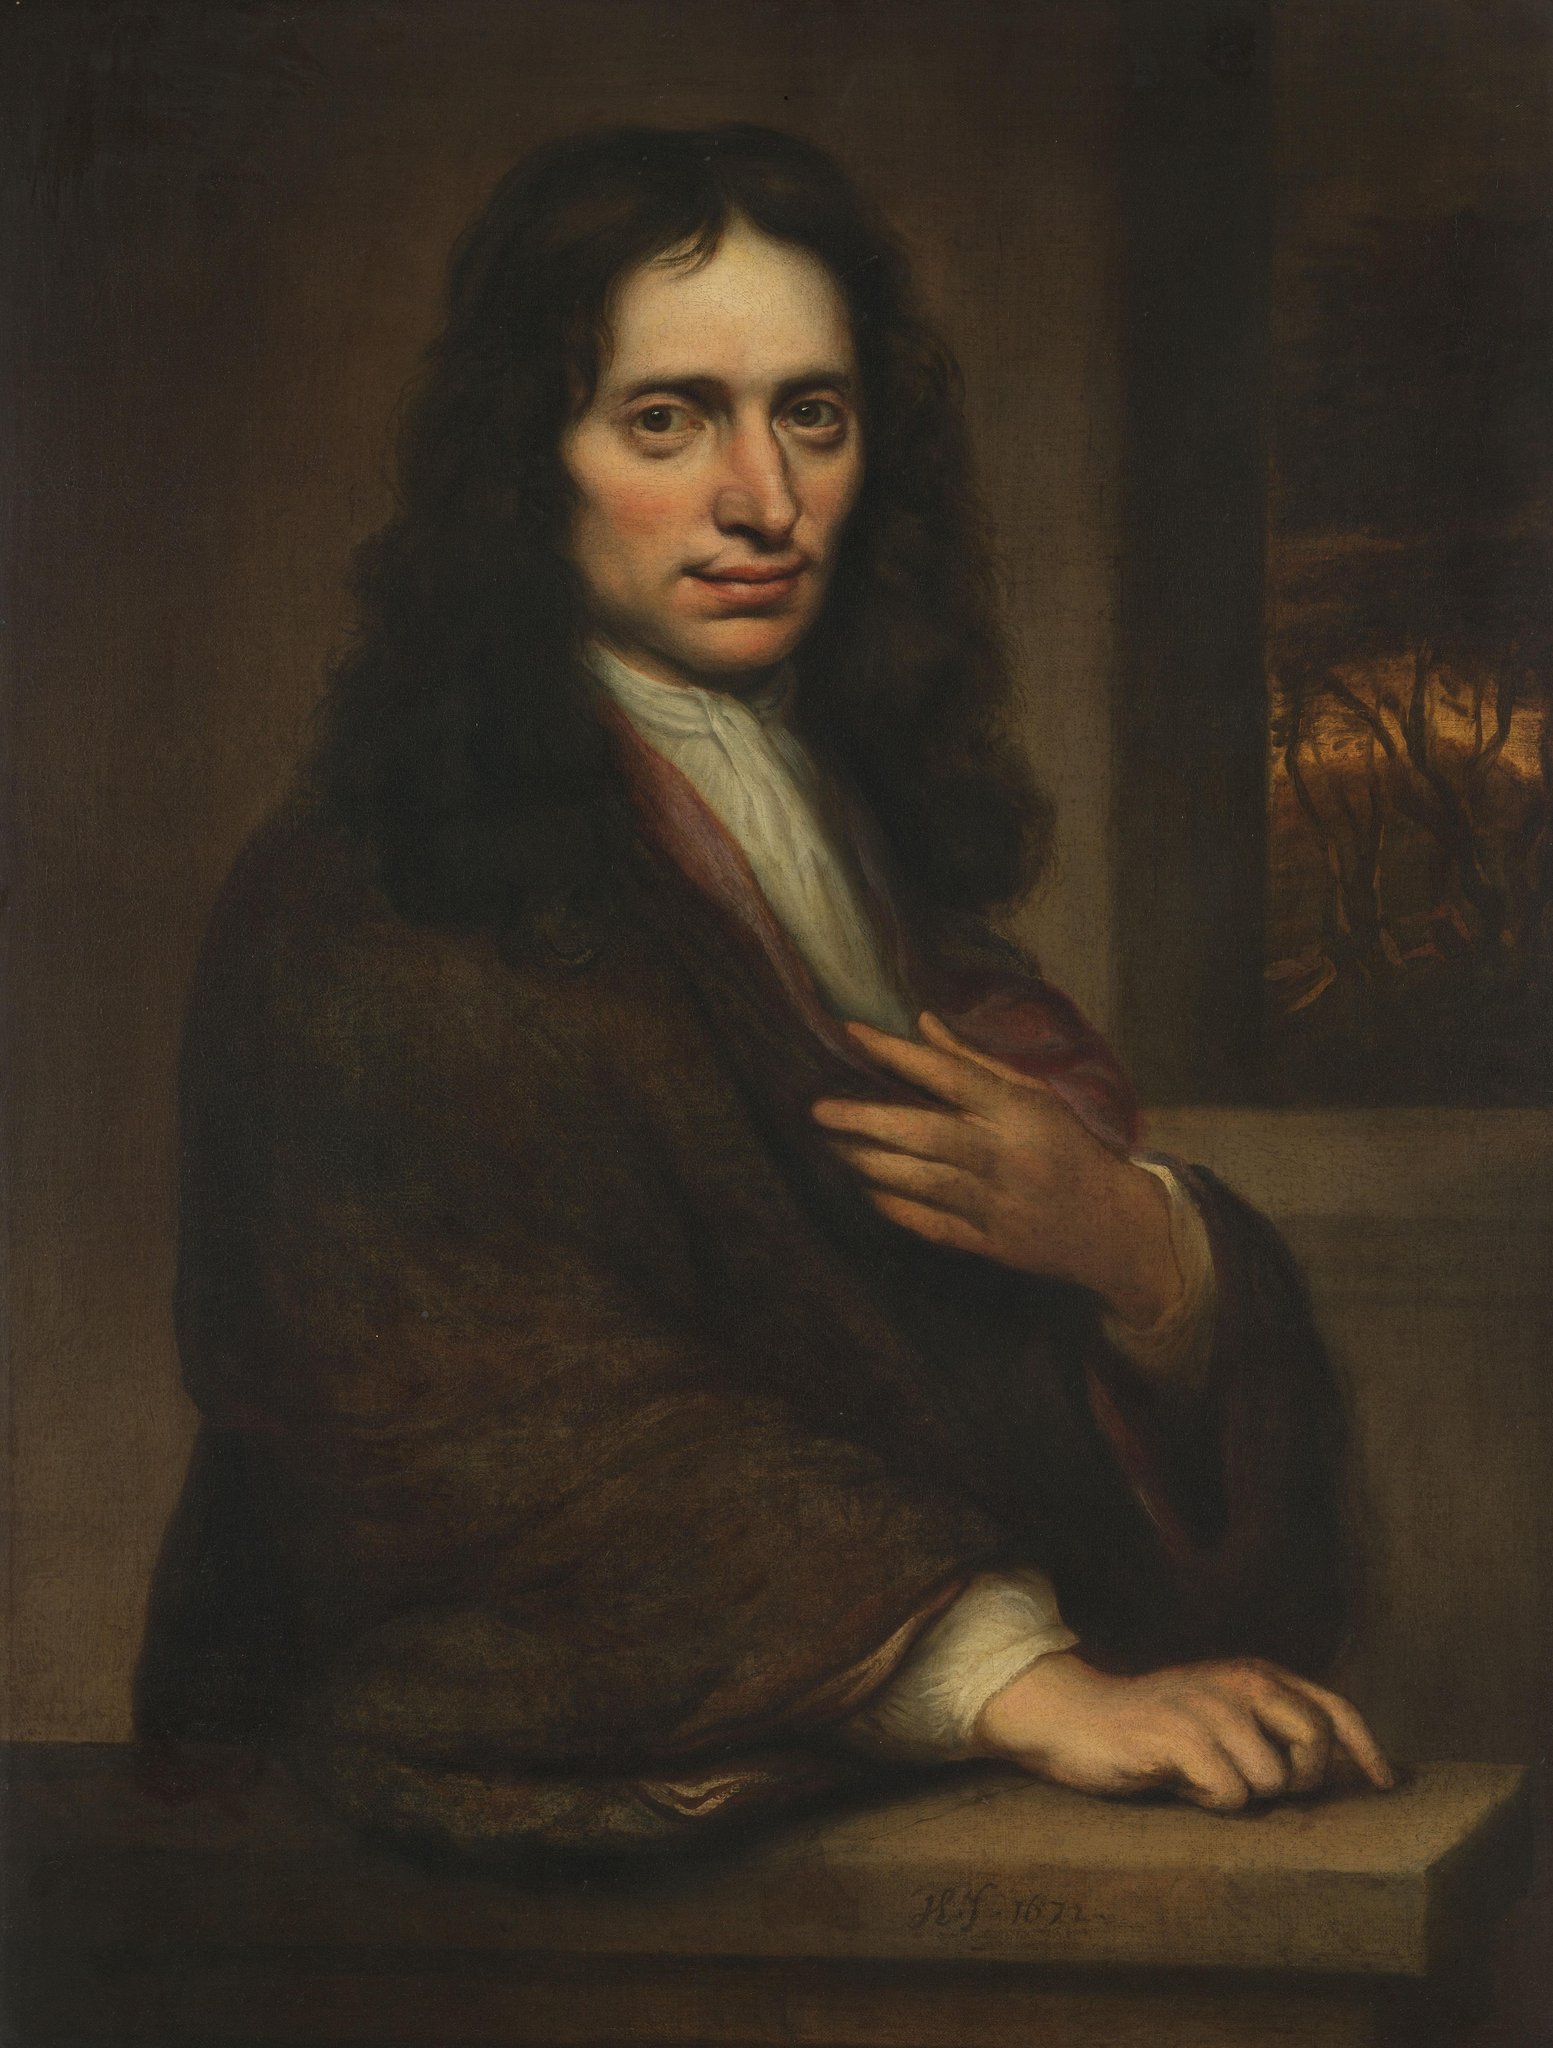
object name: painting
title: Portrait of a Man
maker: jacobus levecq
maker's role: painter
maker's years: 1634-1675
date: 1672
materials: canvas, oil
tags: anonymous historical person portrayed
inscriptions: signature and date: ‘JL. f. 1672.’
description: Portret van een jonge man. Staand, ten halven lijve, leunend met de rechterhand op een balustrade, rechts een venster met landschap.